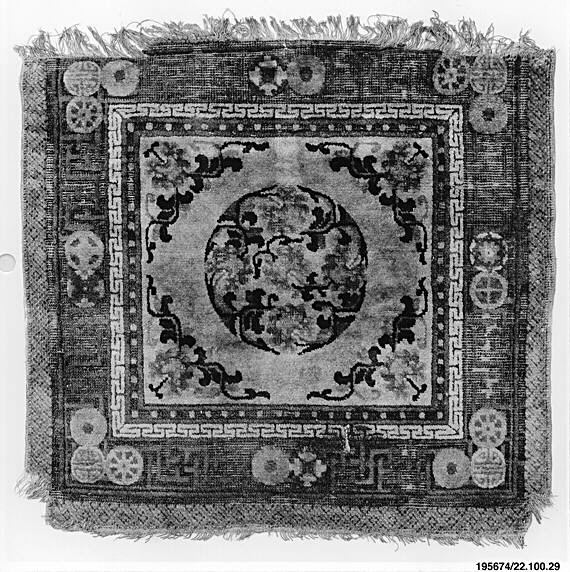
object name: cushion cover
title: Cushion Cover for Chair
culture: chinese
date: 1767-1800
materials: cotton, wool